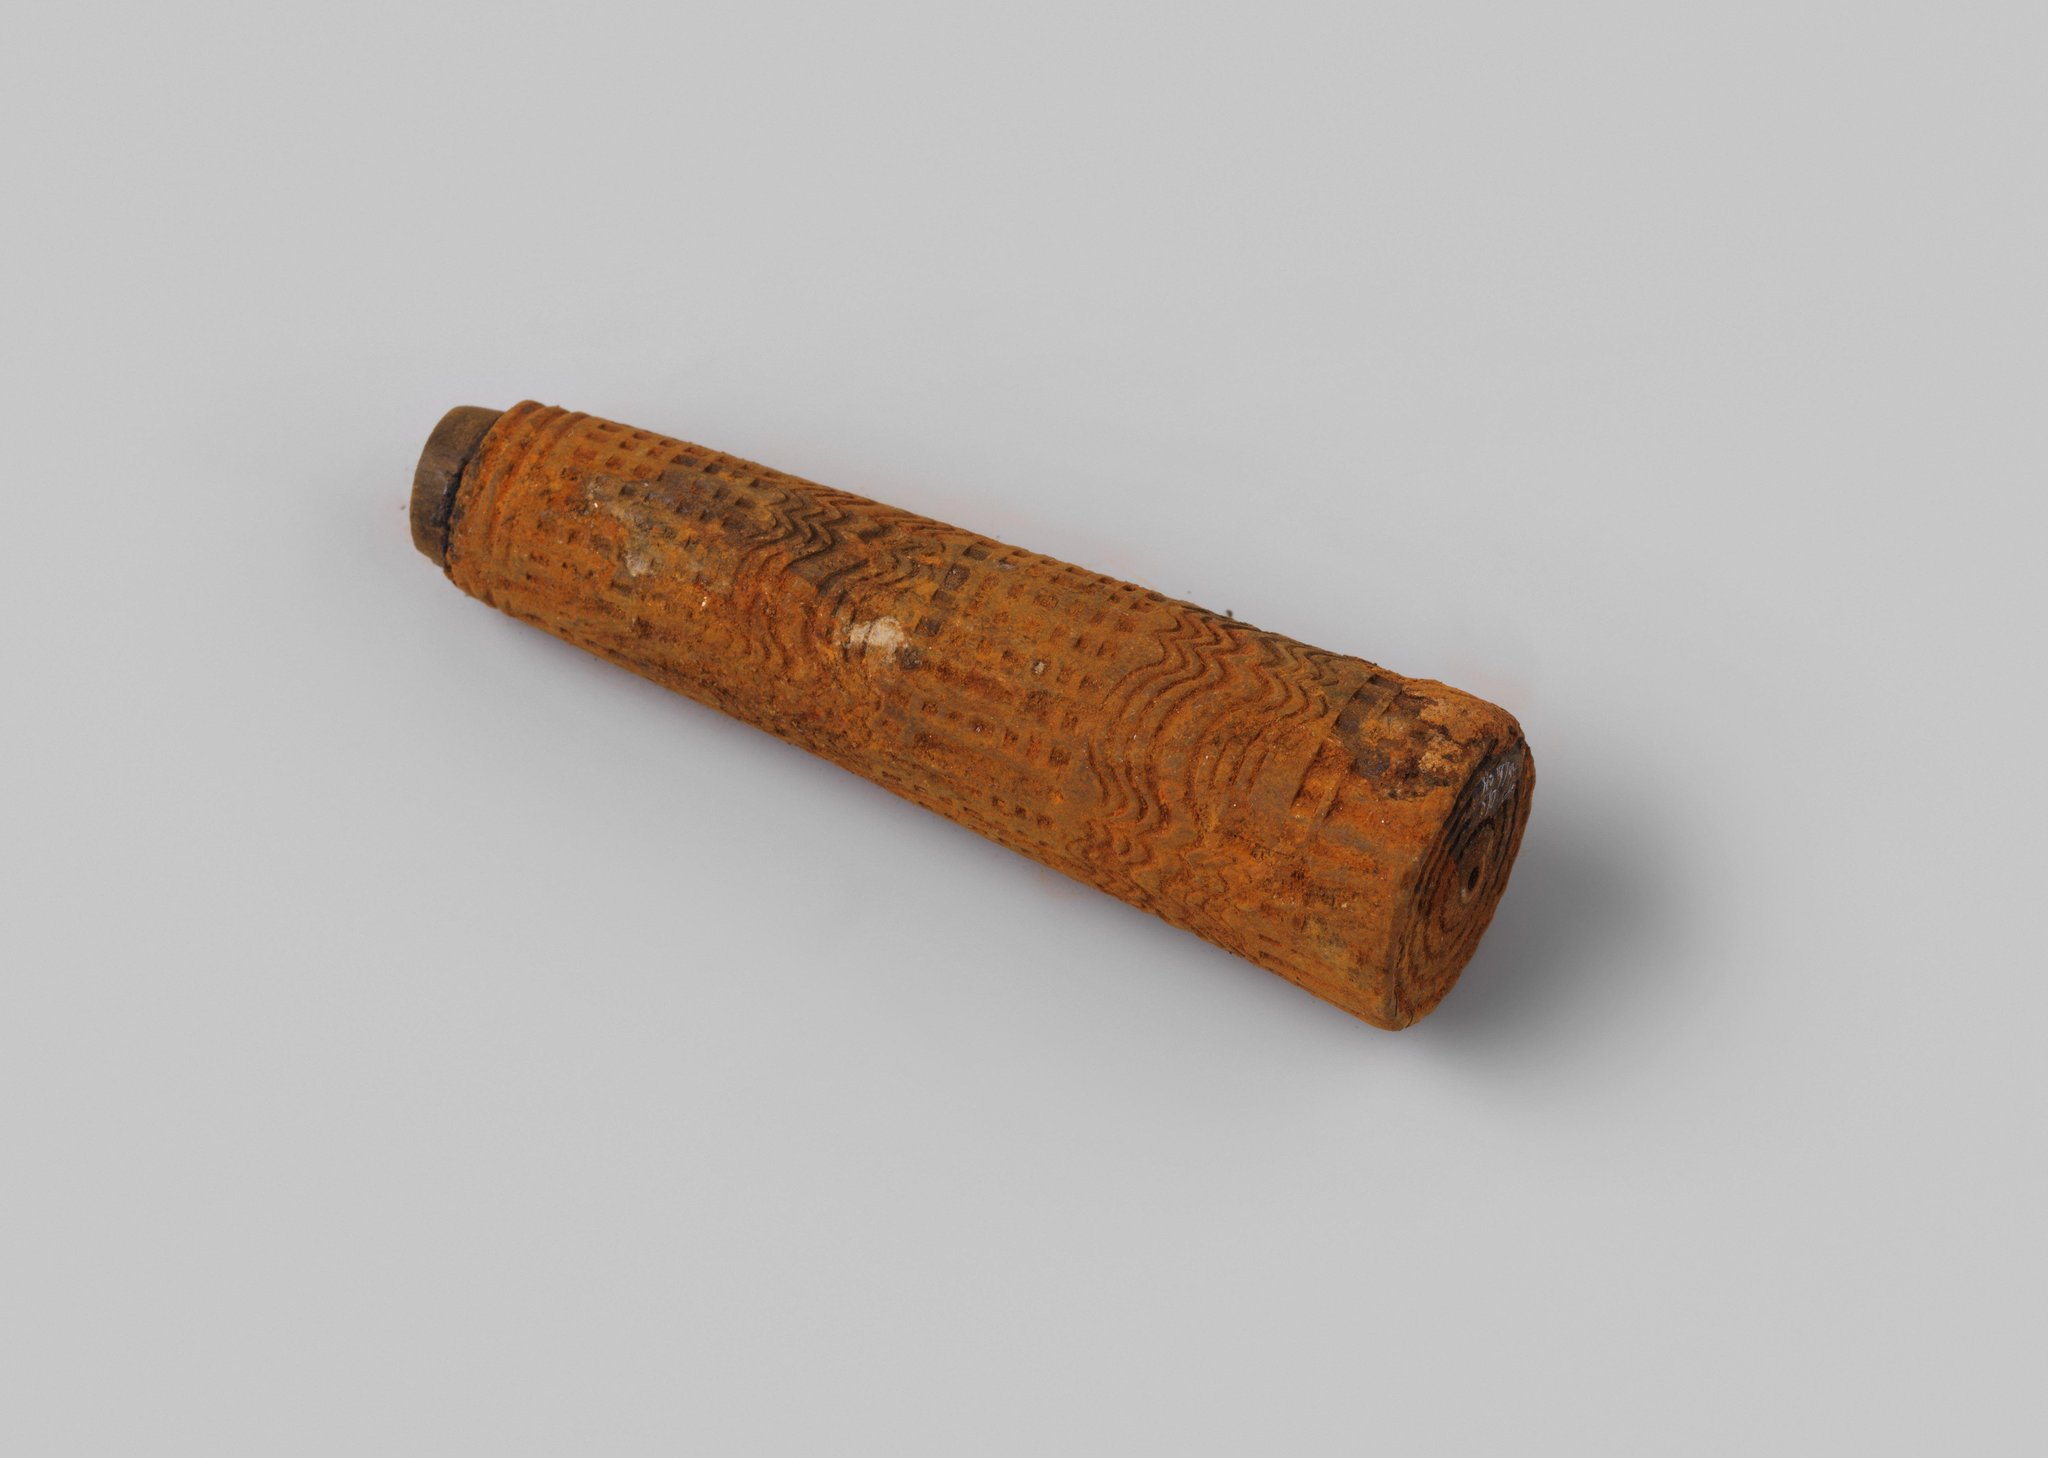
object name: knife handle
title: Messenheft uit het wrak van de Oost-Indiëvaarder Hollandia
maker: Anonymous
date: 1700-1743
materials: wood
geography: netherlands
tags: verenigde oostindische compagnie, hollandia (schip), annet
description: Knife, handle, cylindrical: tapering; id. NG 1979-403H, ferrules id. NG 1980-27H426.